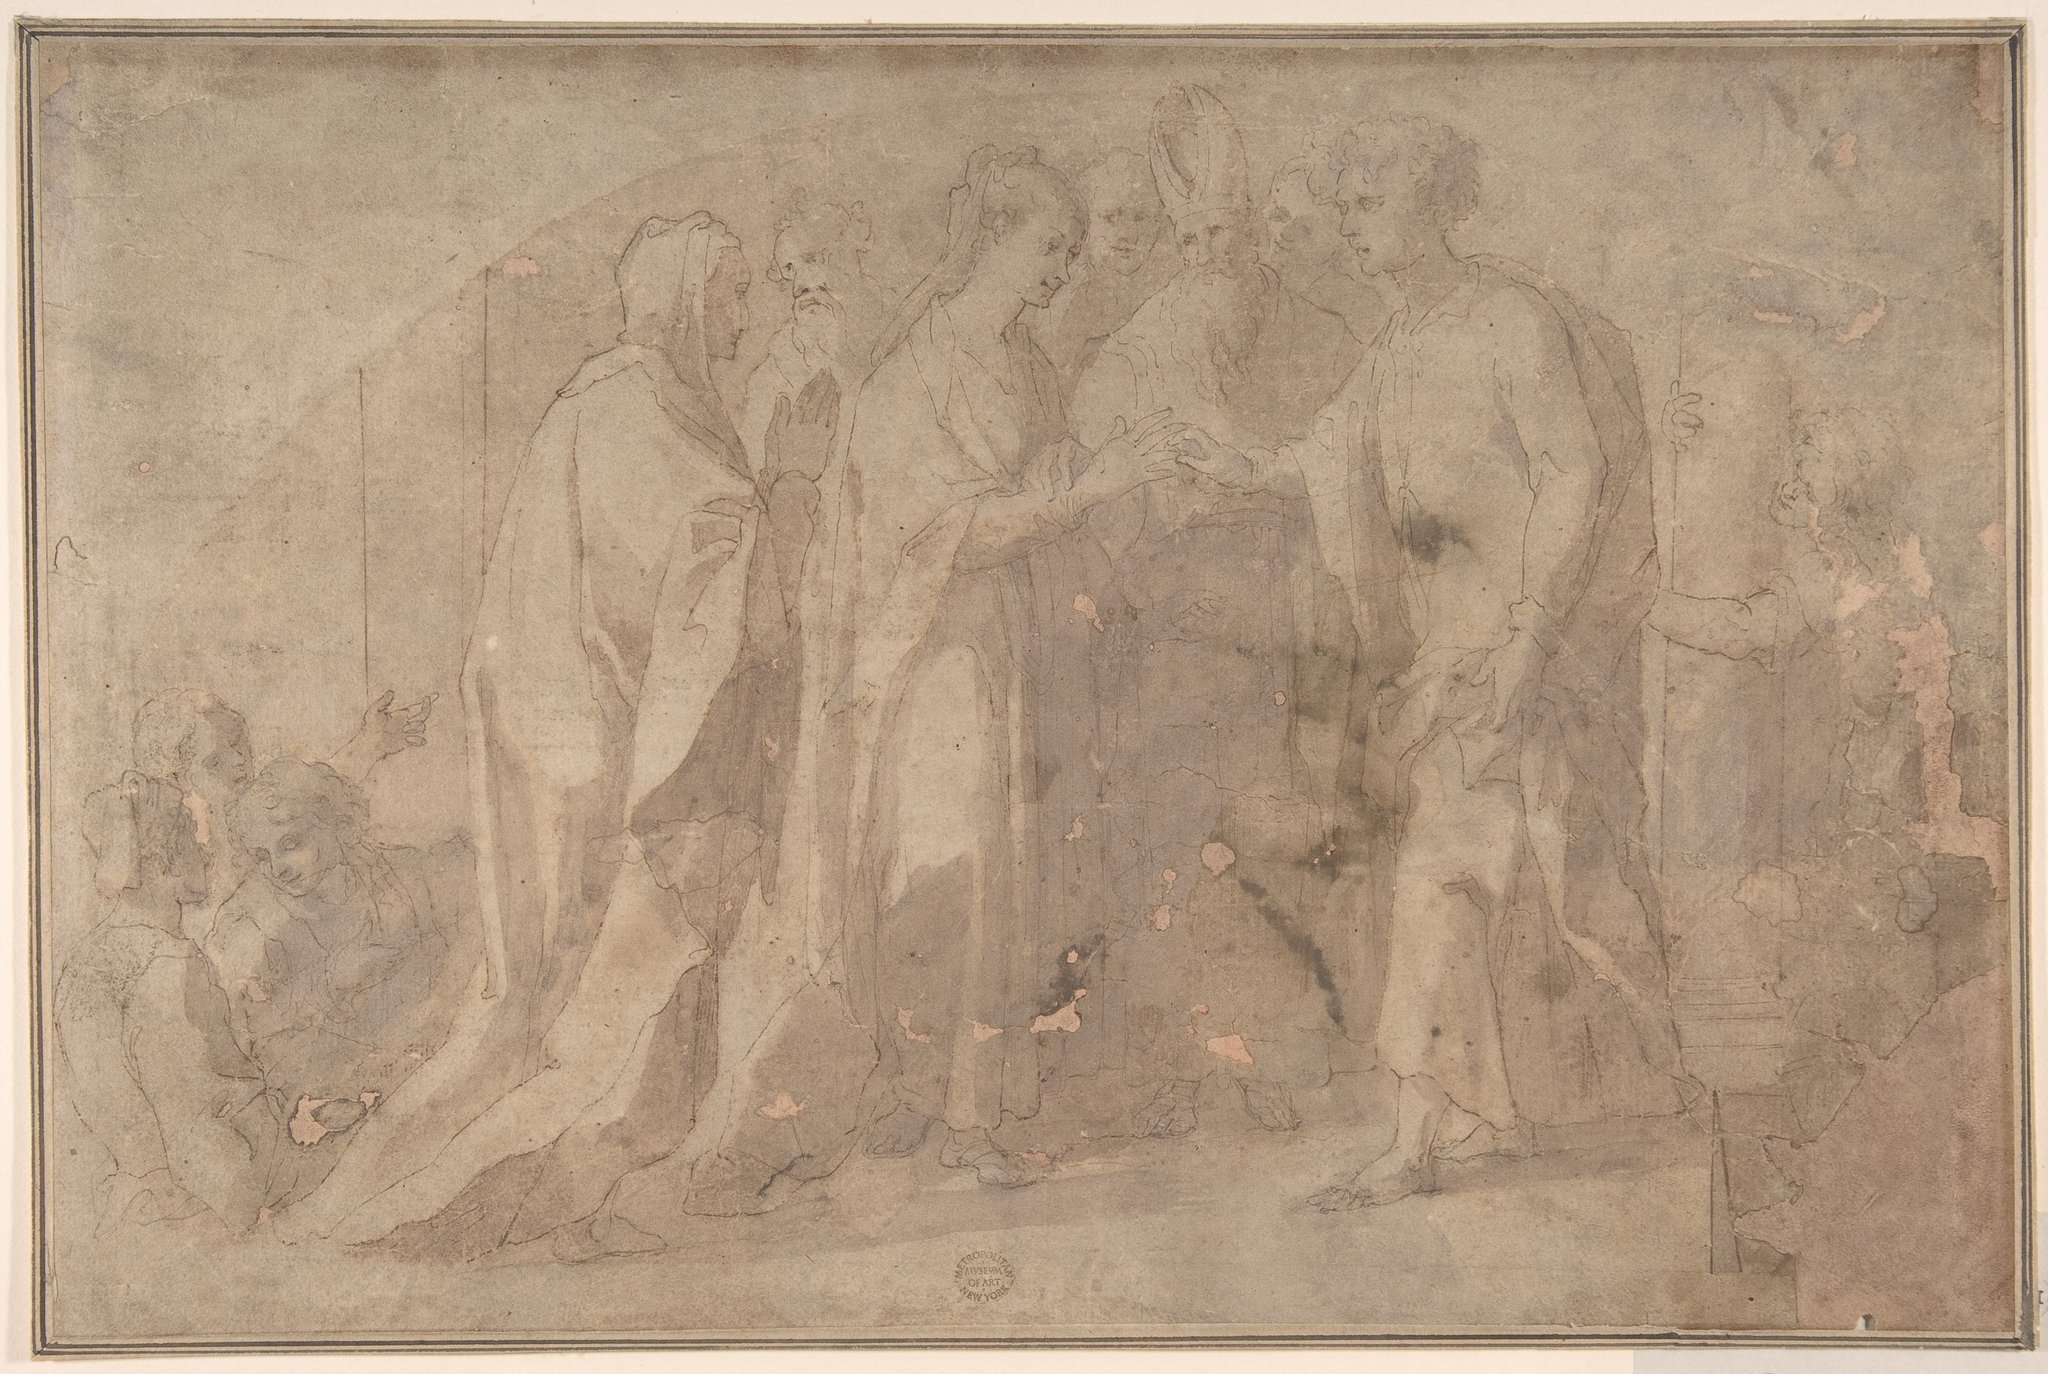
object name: drawing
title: The Marriage of the Virgin (Lunette)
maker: giorgio picchi, the younger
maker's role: artist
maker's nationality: italian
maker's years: 1555-1605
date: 1580-1600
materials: chalk, ink, paper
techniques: brush, pen, wash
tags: men,women,virgin mary